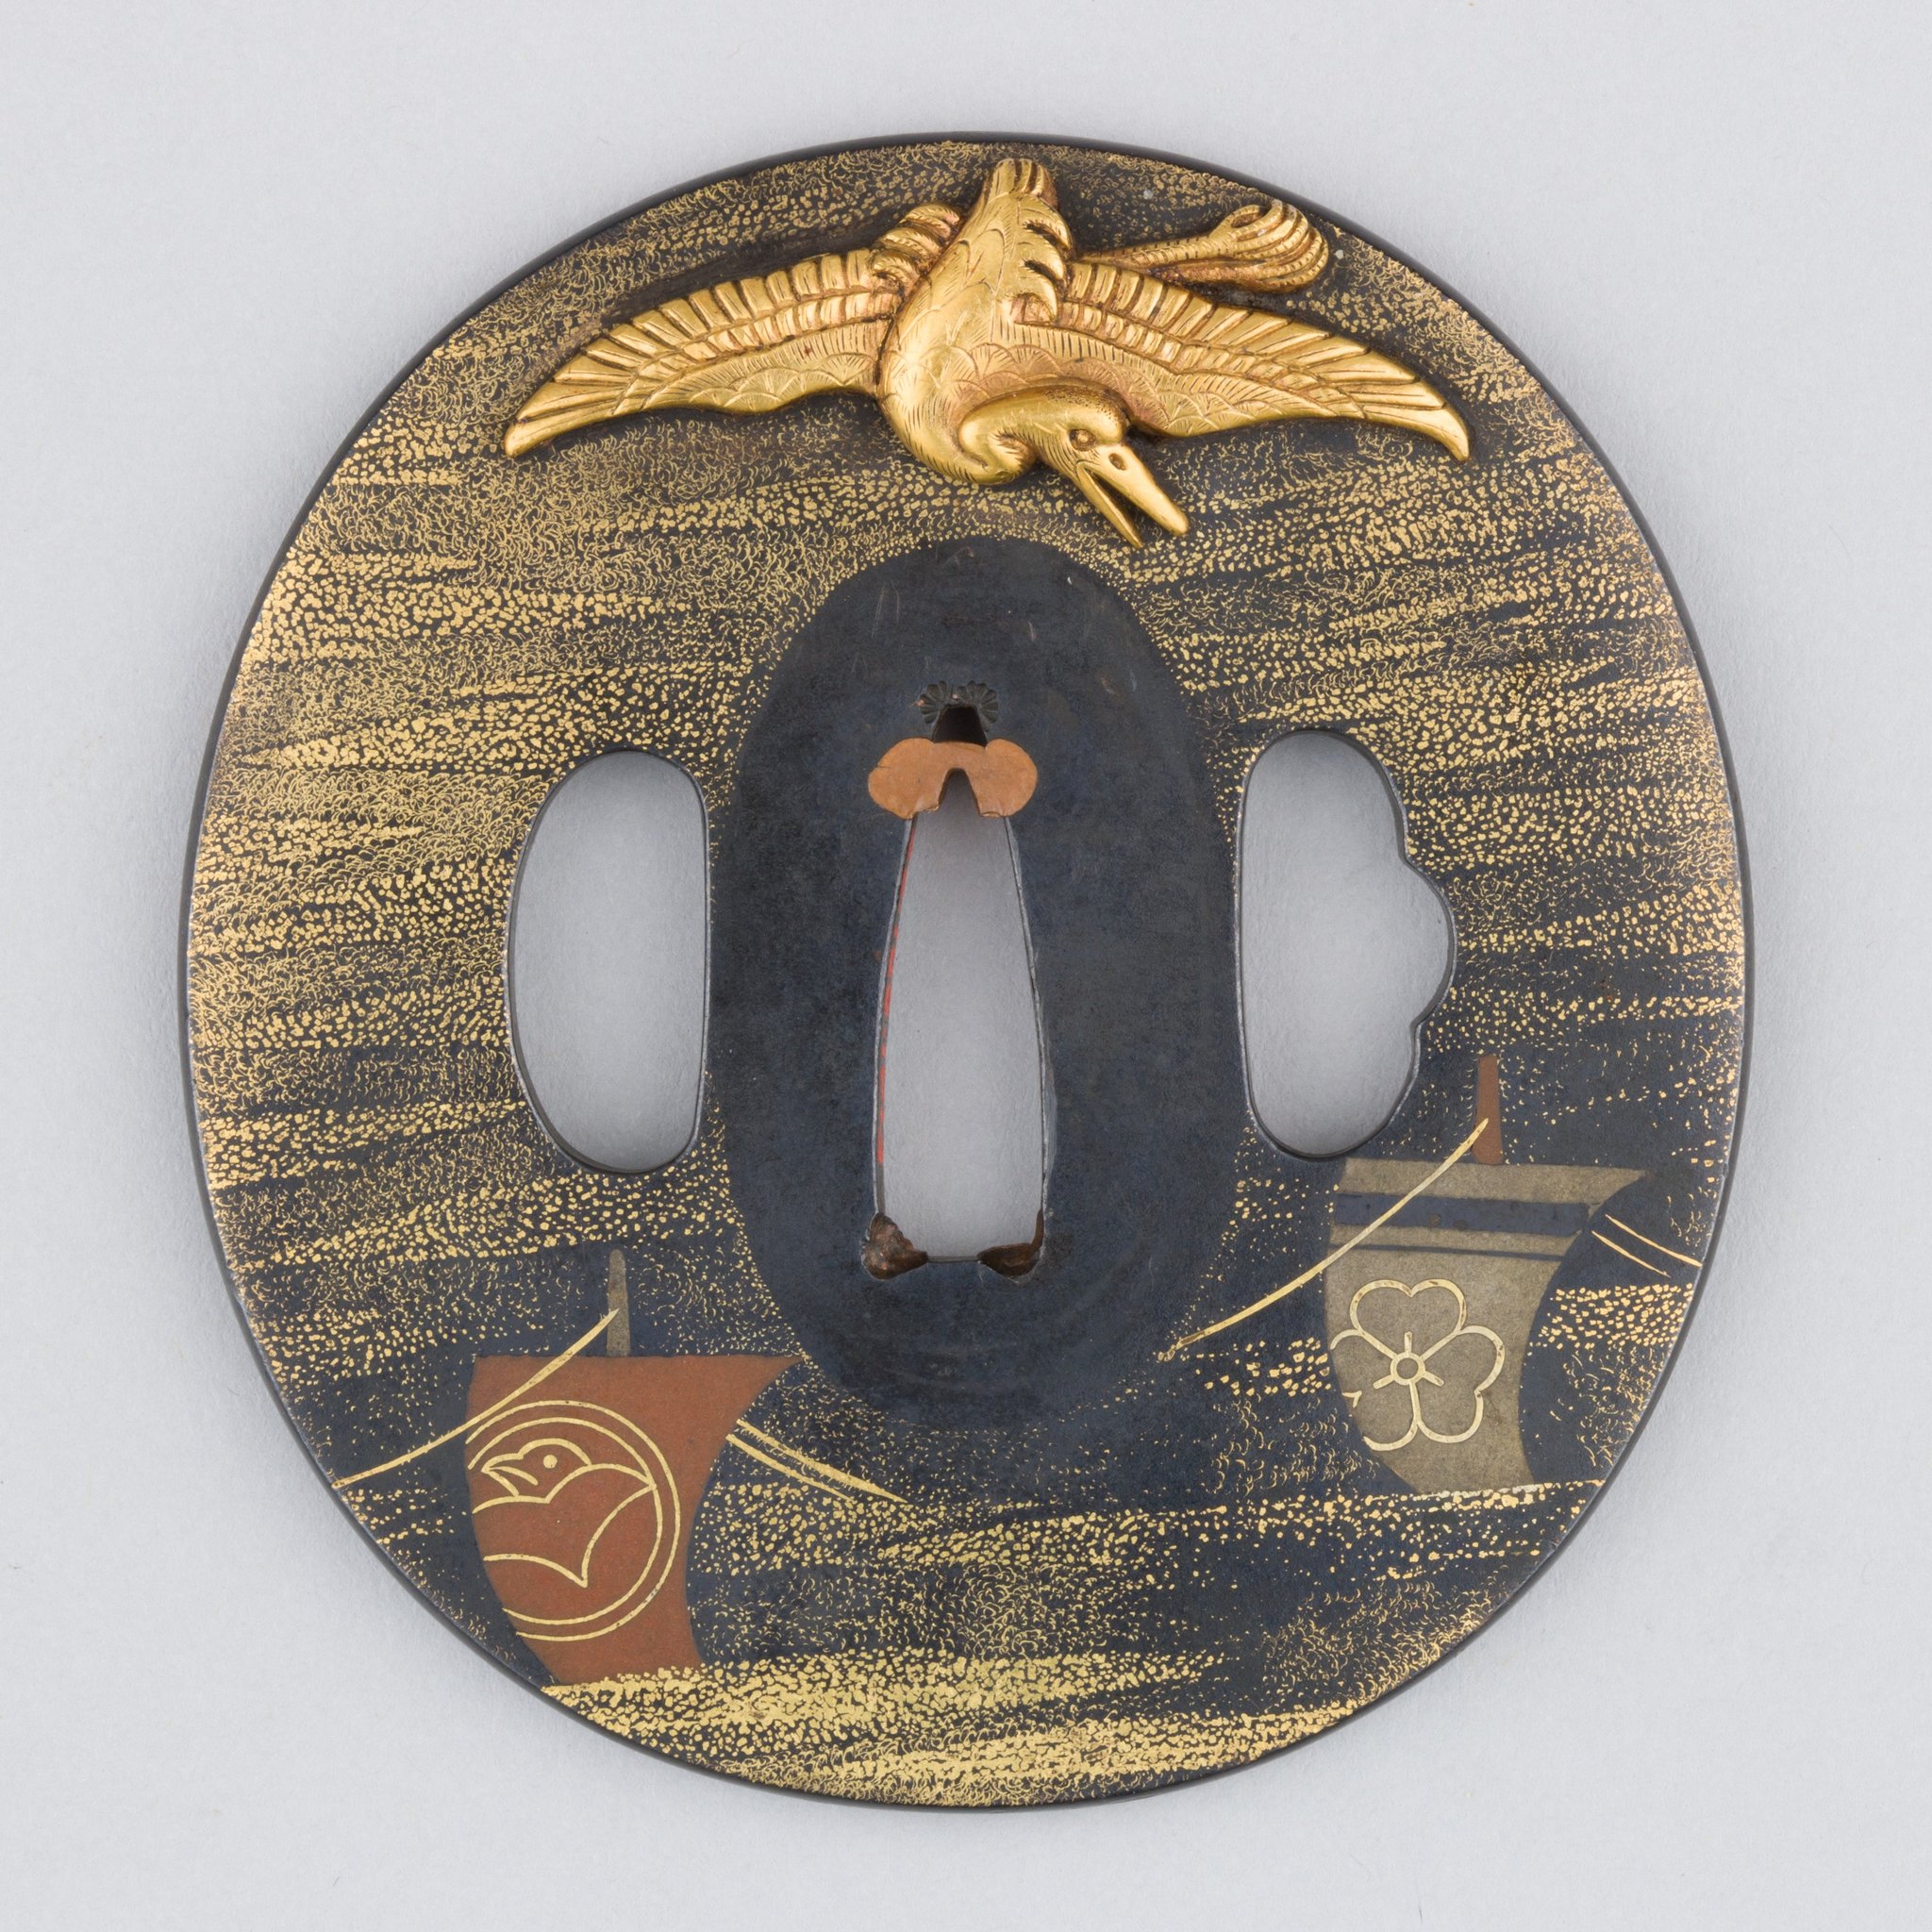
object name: sword guard tsuba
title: Sword Guard (Tsuba)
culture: japanese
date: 1615-1868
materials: copper, gold alloy, silver alloy, gold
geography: japan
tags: birds